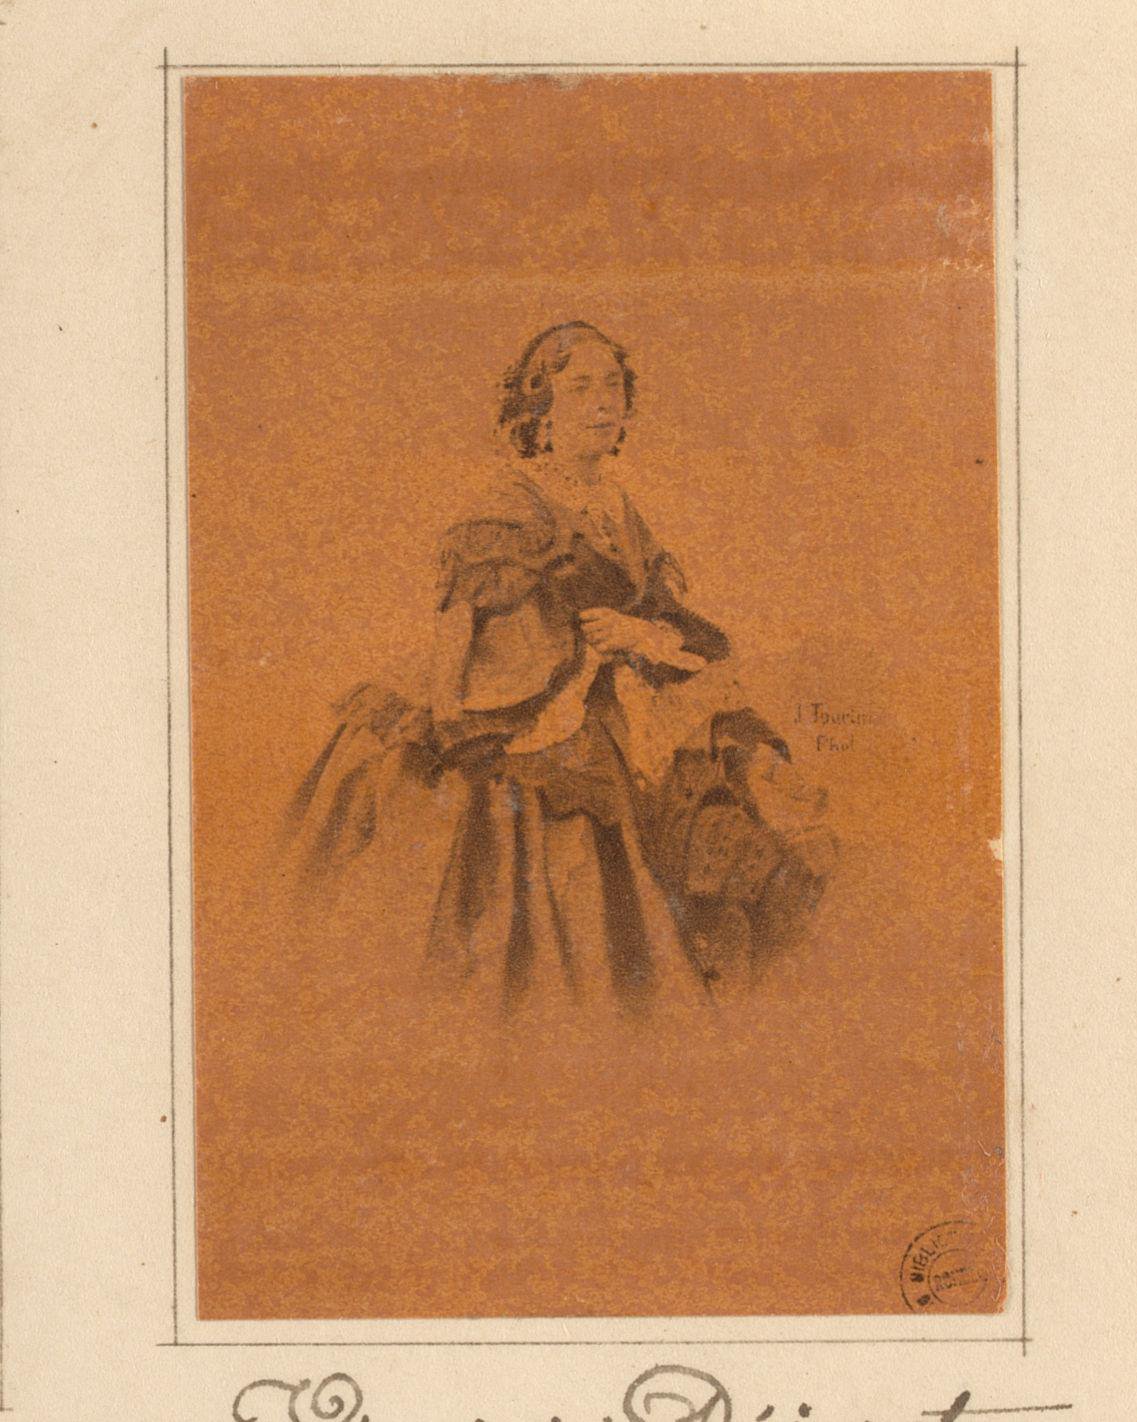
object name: album leaf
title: Virginie Déjazet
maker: Anonymous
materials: paper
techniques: rotogravure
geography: france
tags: portrait of actor, actress, france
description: Deze prent maakt deel uit van een album.